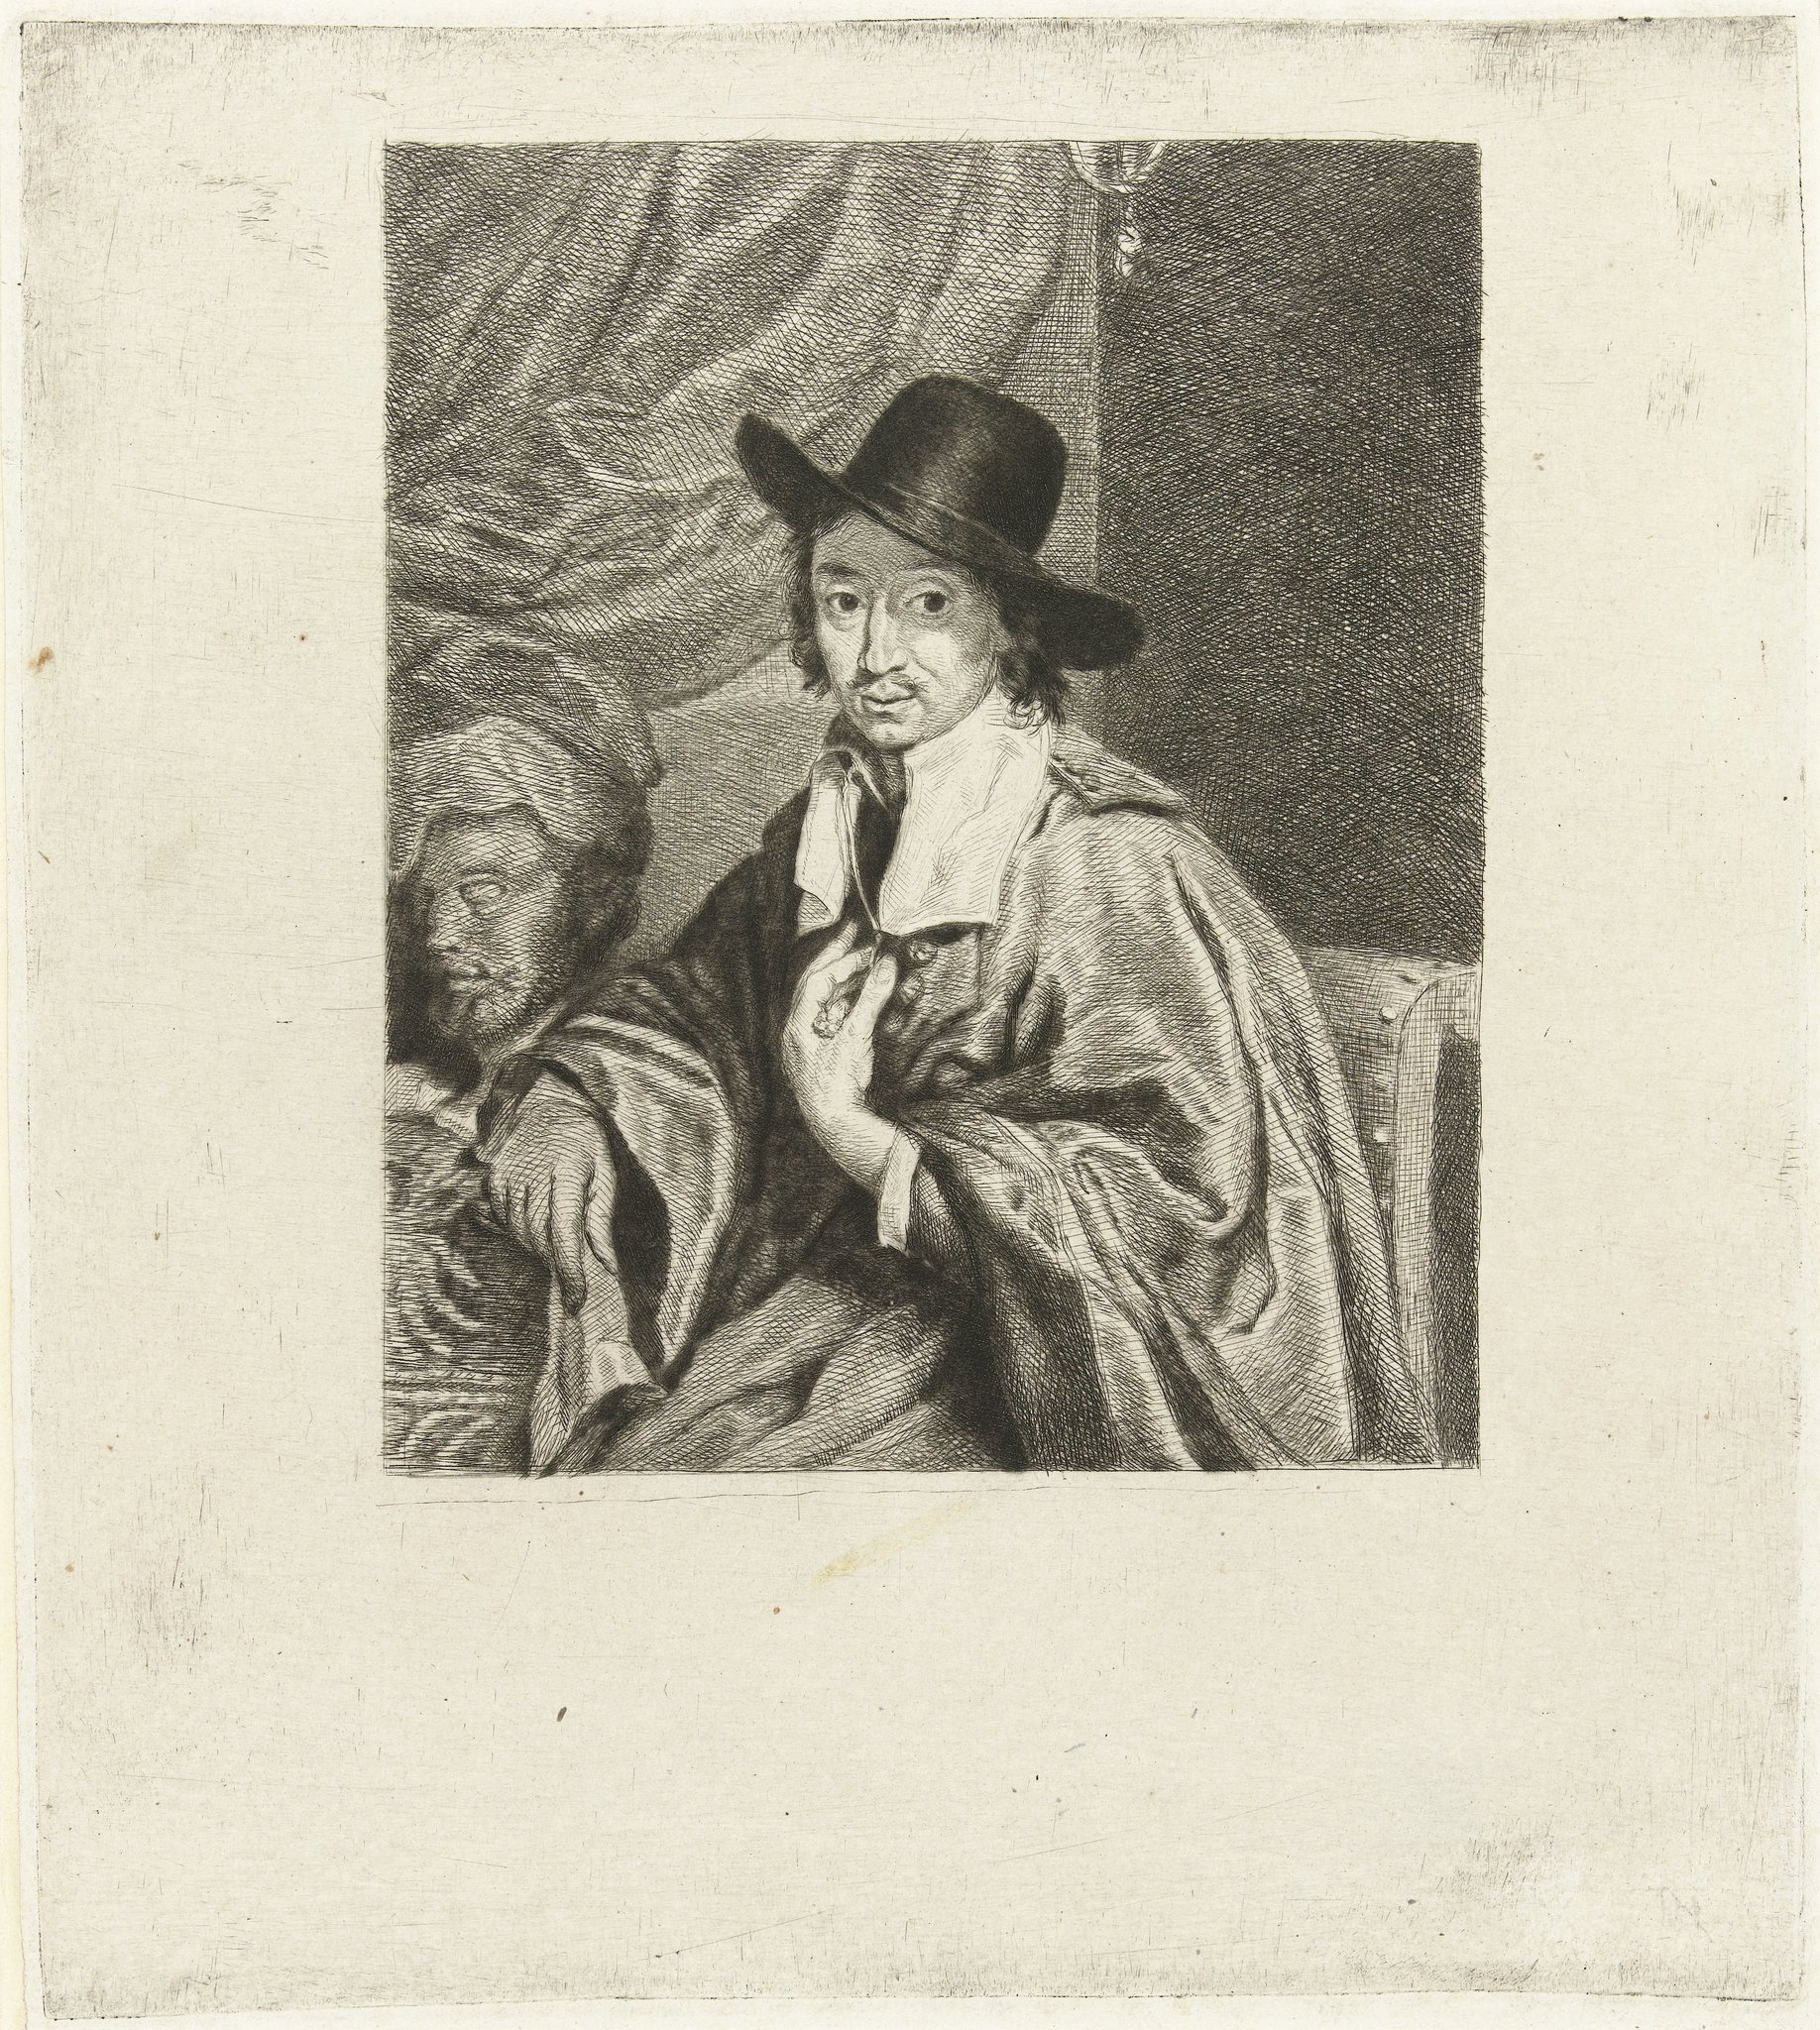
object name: print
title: Portret van de schilder Adriaen van Ostade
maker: louis bernard coclers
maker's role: draughtsman, print maker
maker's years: 1741-1817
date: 1756-1817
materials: paper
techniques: drypoint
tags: haarlem, painter, adriaen van ostade, portrait, self-portrait of artist (+ artist in non-work situation)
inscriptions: collector's mark: Lugt 240